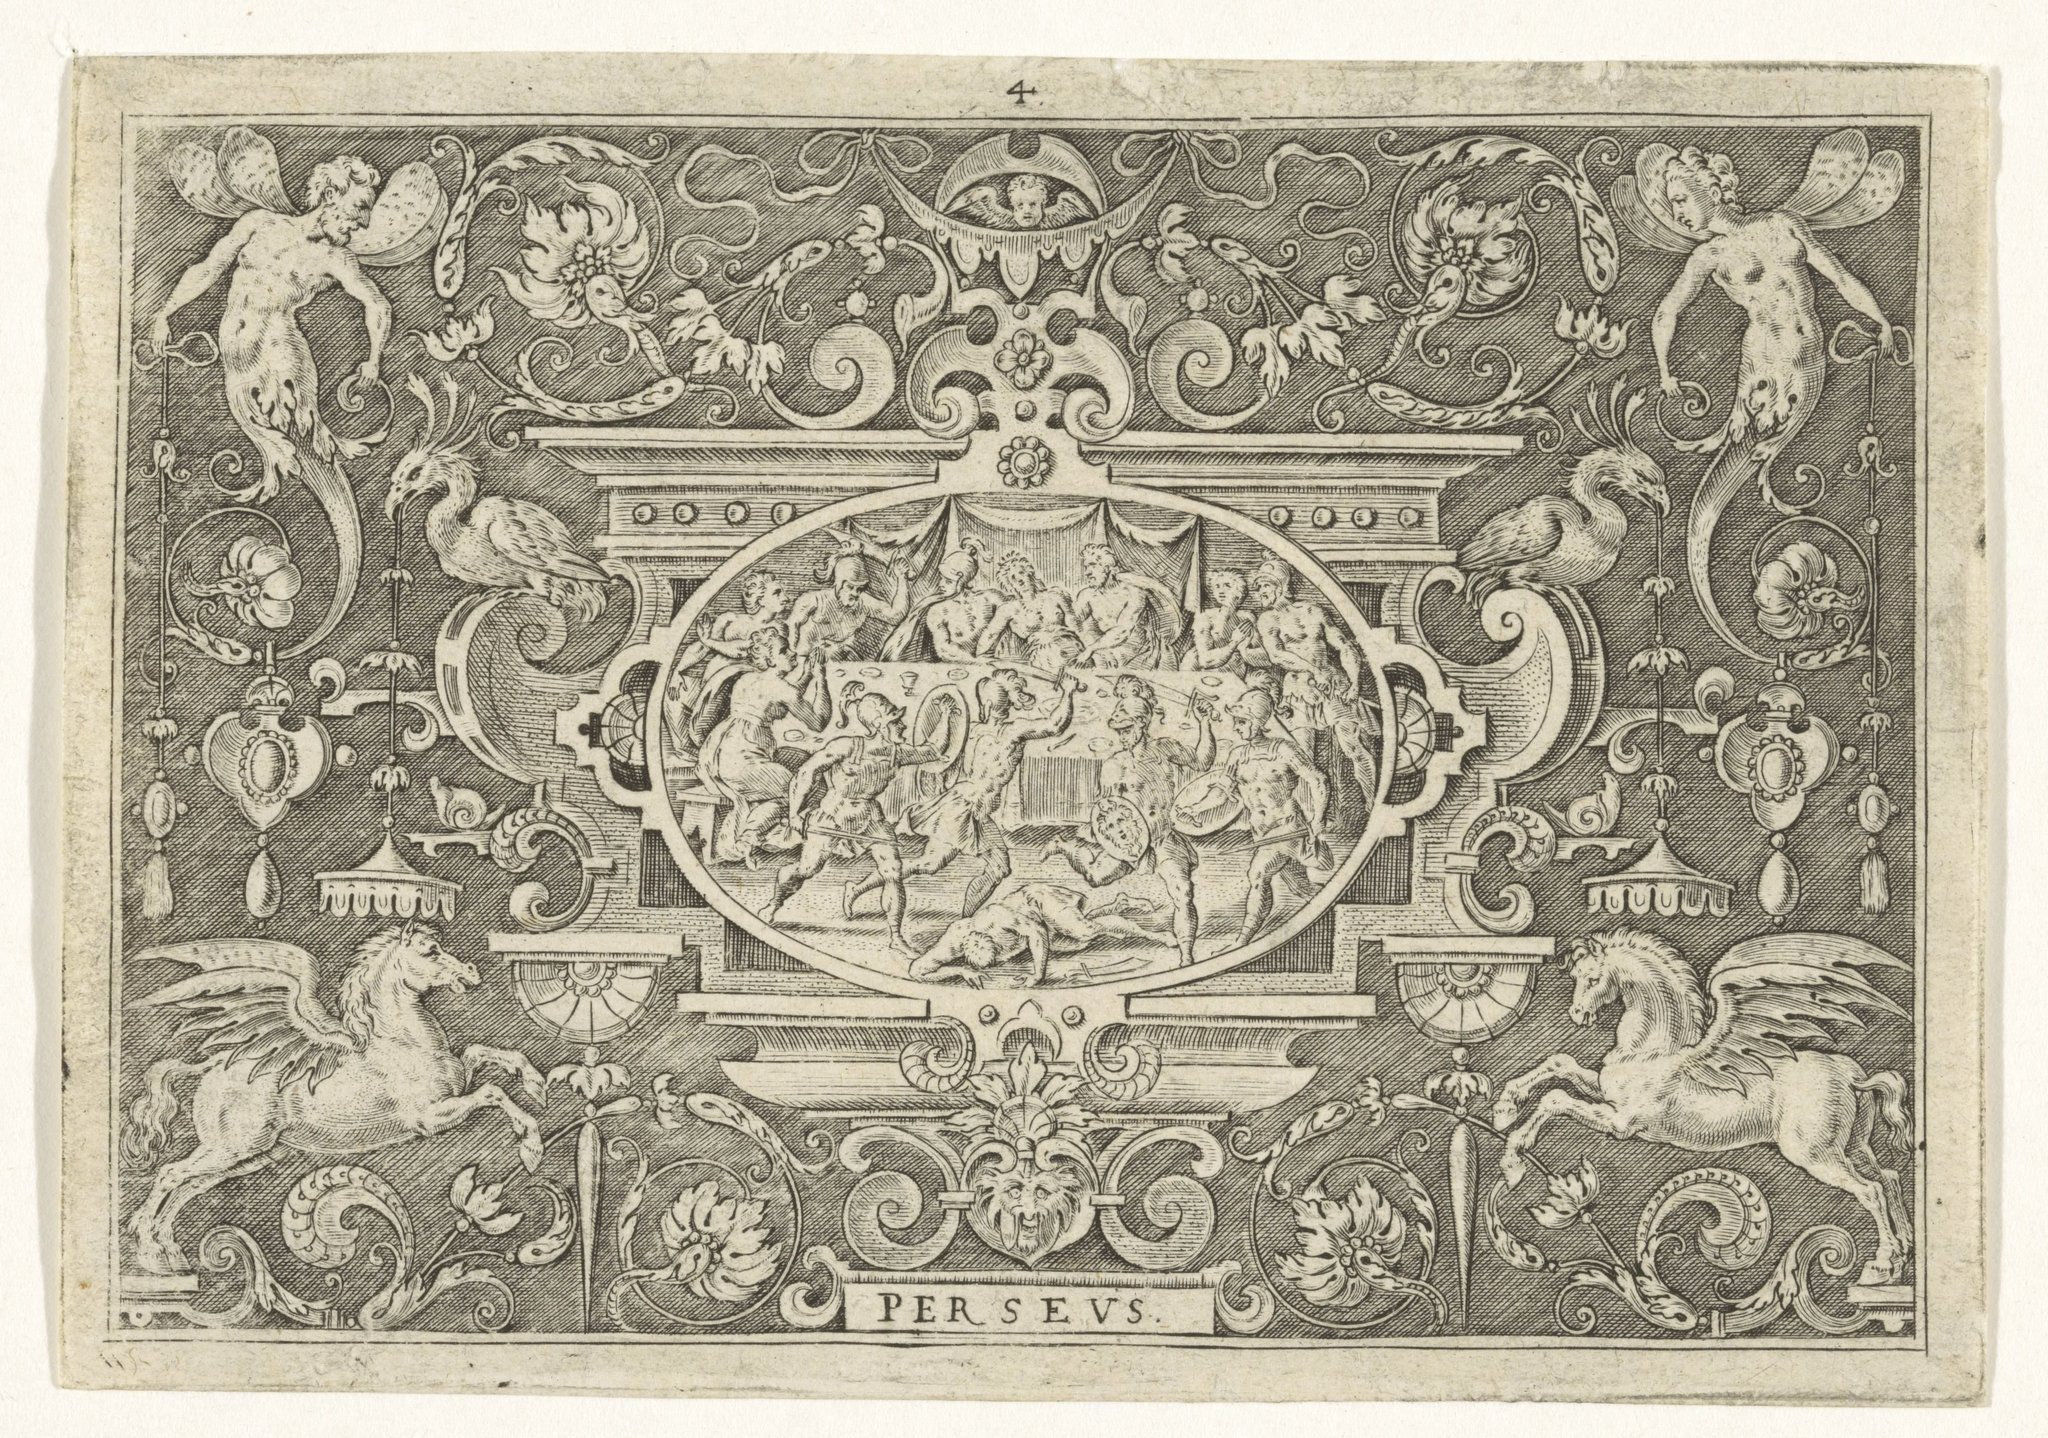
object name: ornament print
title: PERSEUS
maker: abraham de bruyn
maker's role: print maker, publisher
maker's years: 1540-1587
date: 1584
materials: paper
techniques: engraving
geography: netherlands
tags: ornament ~ grotesque, ornament ~ cartouche, the wedding-feast of perseus and andromeda is interrupted by phineus, a former suitor; a fight ensues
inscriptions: title: ‘PERSEUS’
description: Ovaal Cartouche in ornamentomlijsting met grotesken en twee gevleugelde paarden, tegen een gearceerde achtergrond. In het cartouche de huwelijksmaaltijd van Perseus en Andromeda, die wordt verstoord door Phineus.